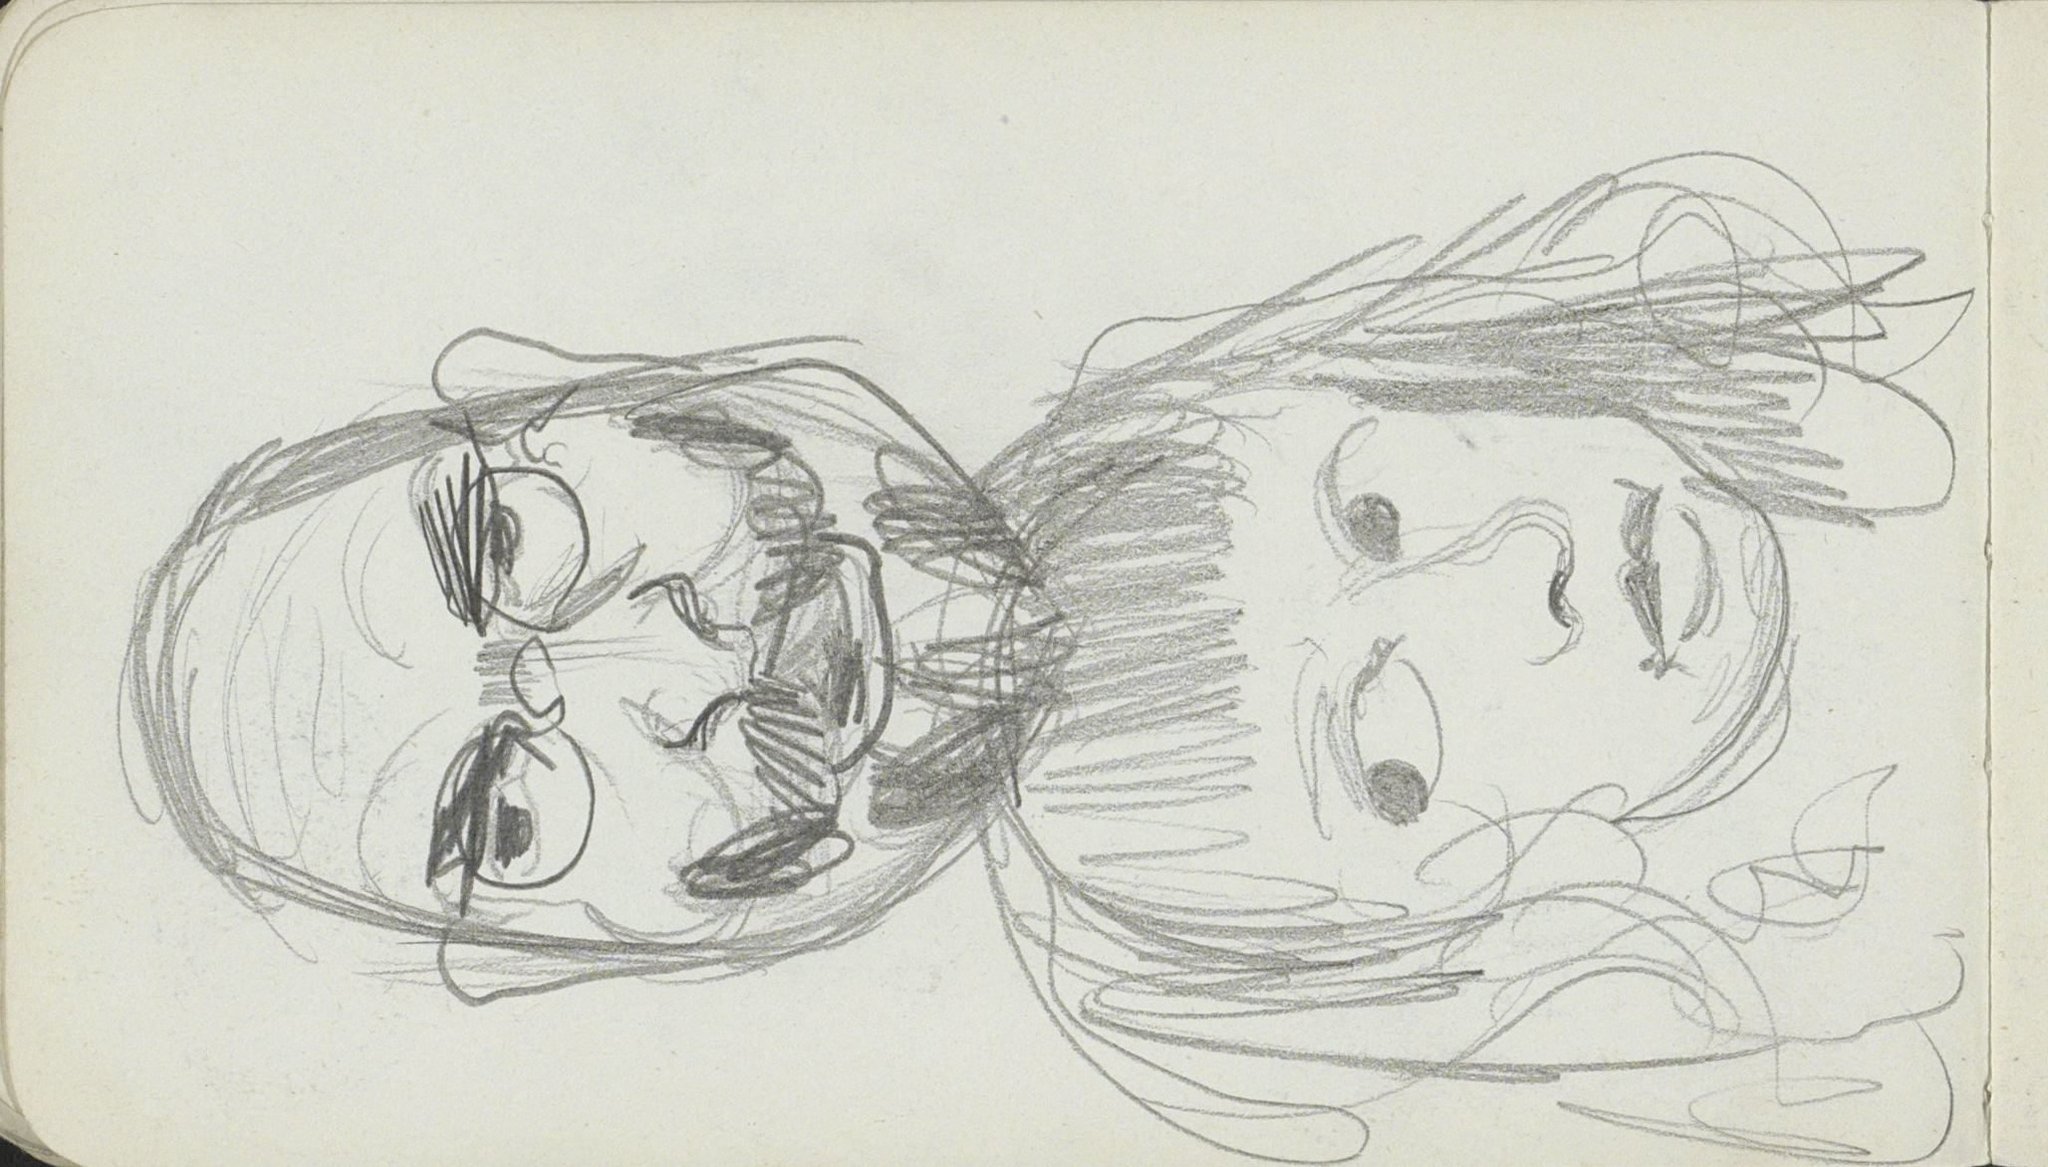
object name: sketchbook leaf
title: Koppen van een meisje en een man met een bril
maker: carel adolph lion cachet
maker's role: draughtsman, print maker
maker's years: 1864-1945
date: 1905-1906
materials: paper, pencil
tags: eyeglasses, spectacles, head (human), adult man, girl (child between toddler and youth)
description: Blad 19 verso uit een schetsboek met 34 bladen.